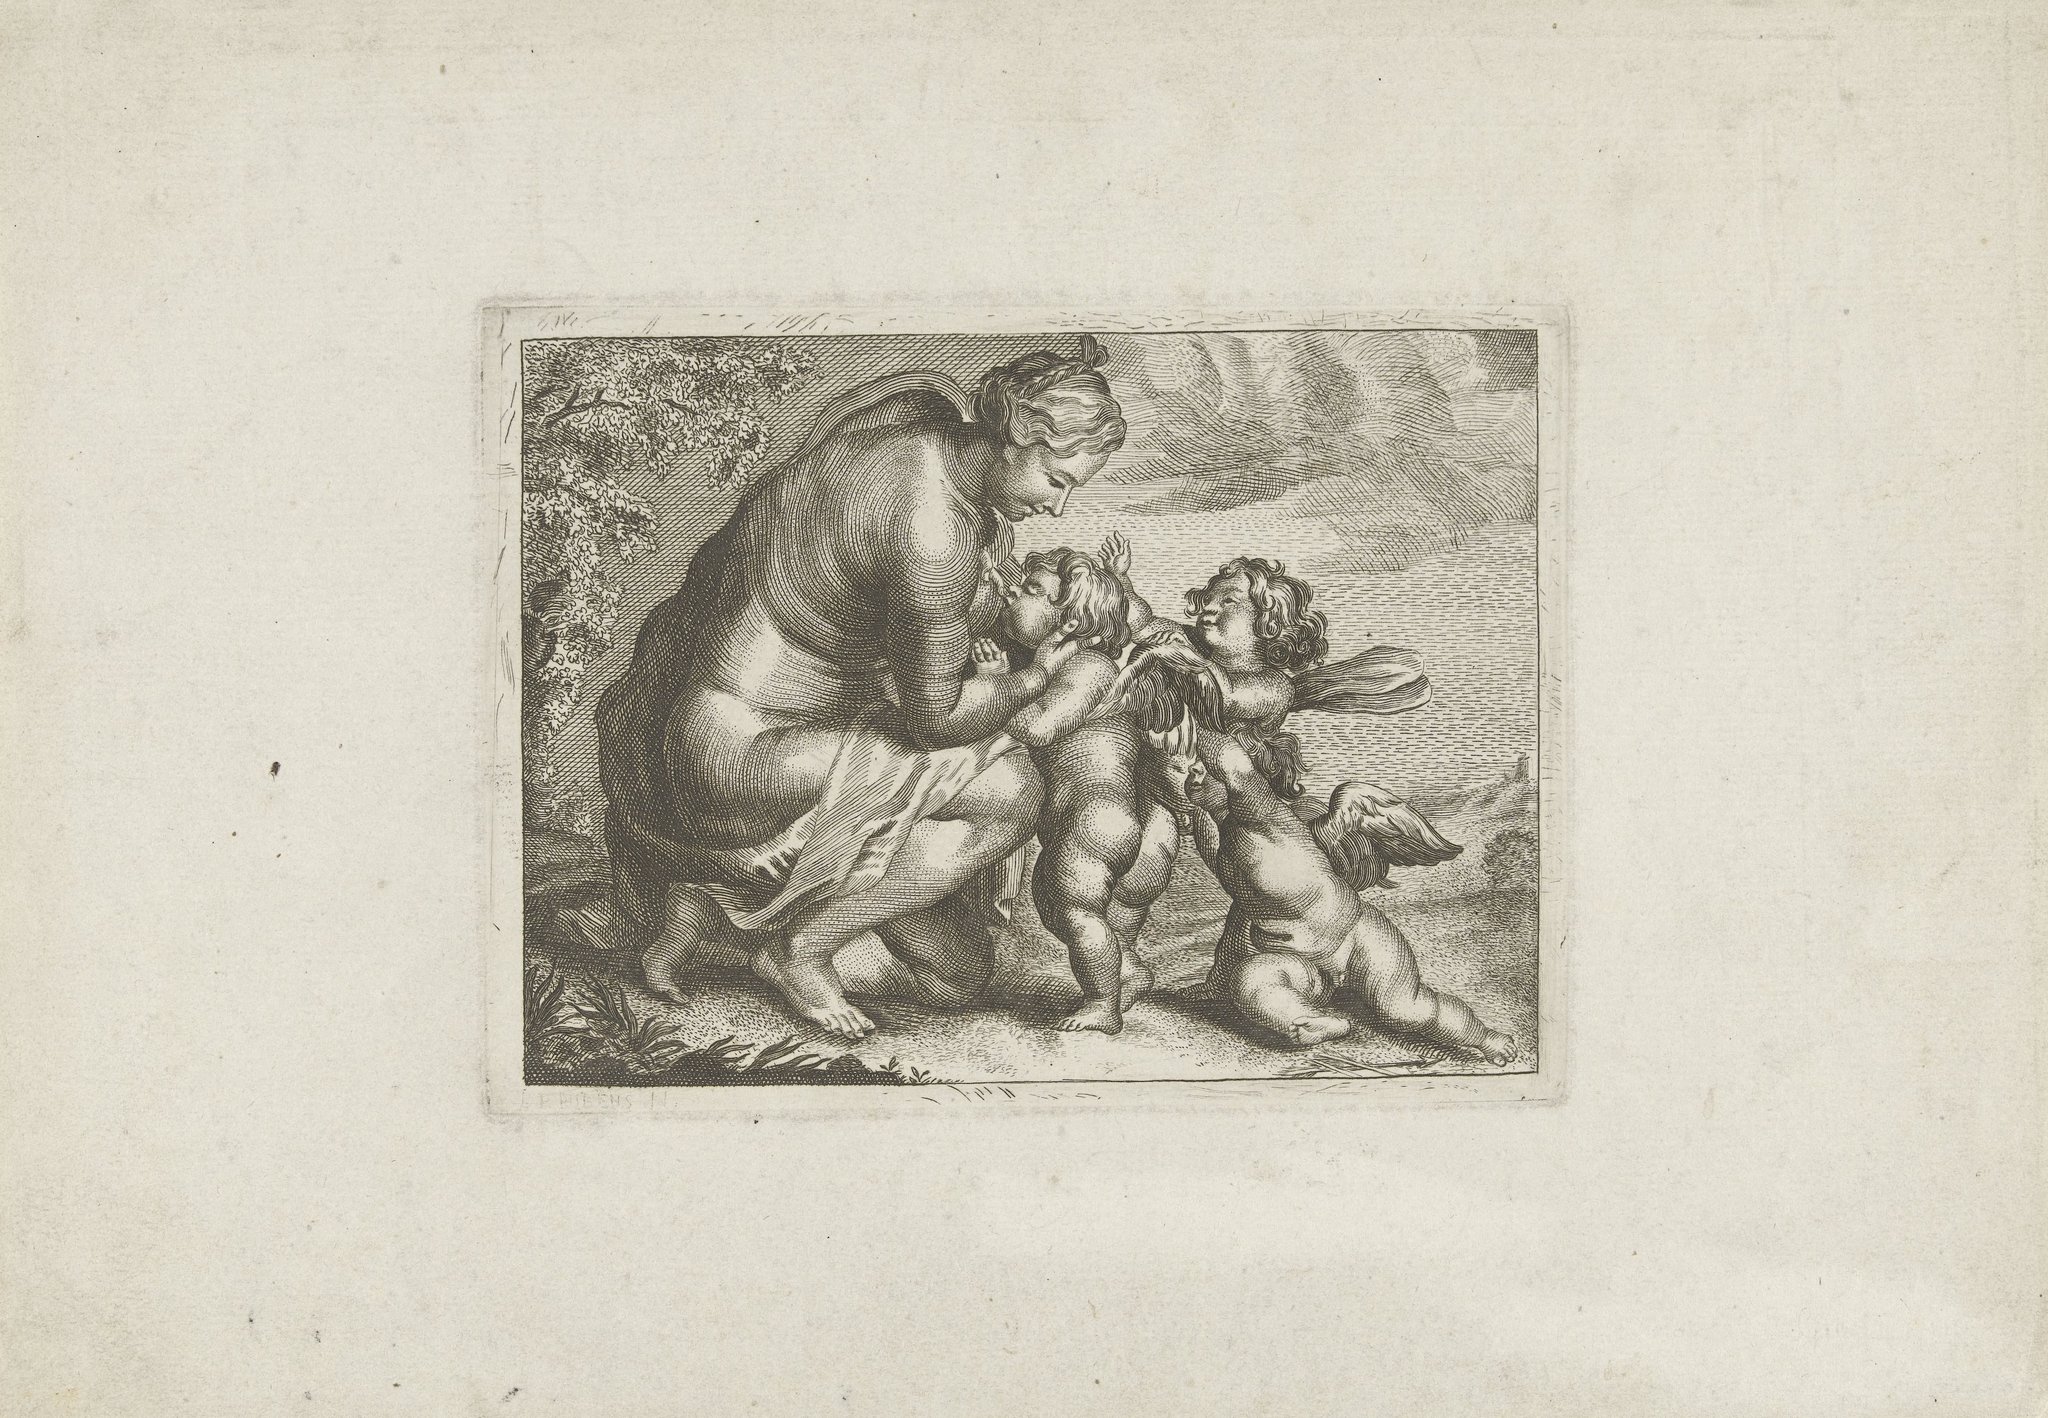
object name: print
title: Venus zoogt drie Amors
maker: Anonymous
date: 1610-1700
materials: paper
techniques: engraving, etching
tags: venus suckling cupid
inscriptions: collector's mark: Lugt 2228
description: Venus knielt op de grond en zoogt Amor. Twee andere putti, eentje met vleugels de ander met libellenvleugels staan in de rij te wachten om ook de borst te krijgen.